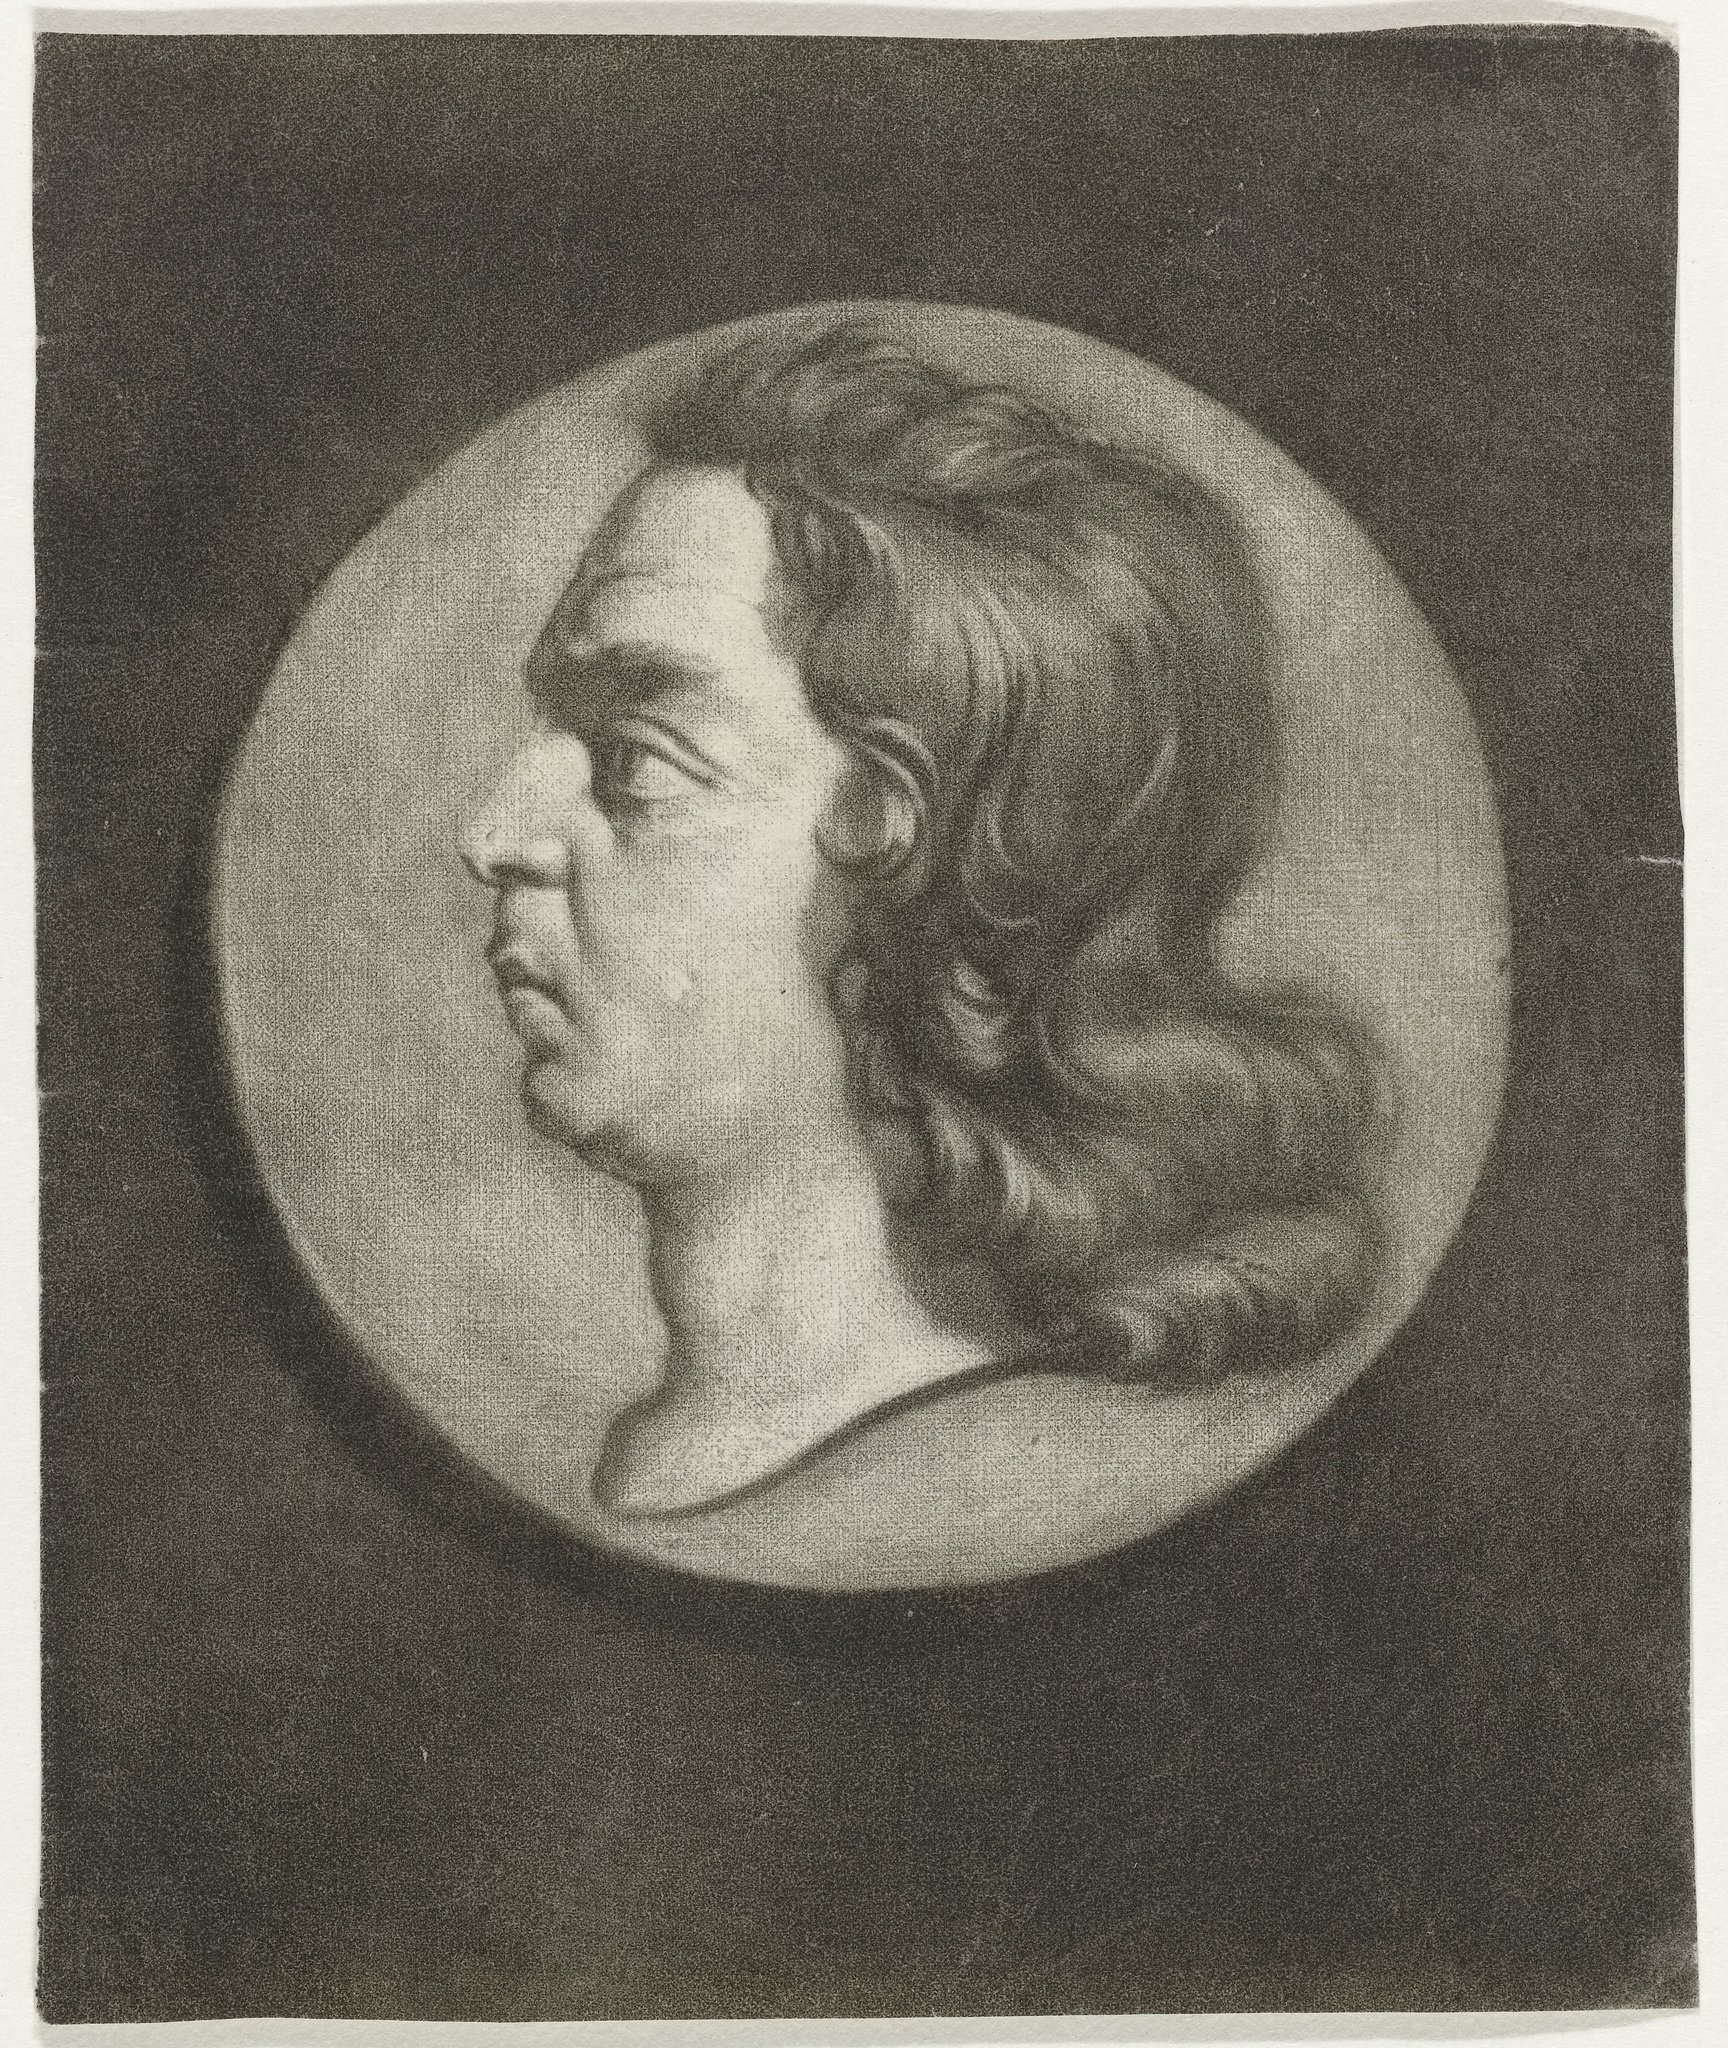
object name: print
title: Portret van Hendricks Haecks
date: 1683-1746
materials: paper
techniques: mezzotint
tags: koopman, haecks, henricksz.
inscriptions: collector's mark: Lugt 240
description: De Duitse koopman Hendricks Haecks, in profiel.